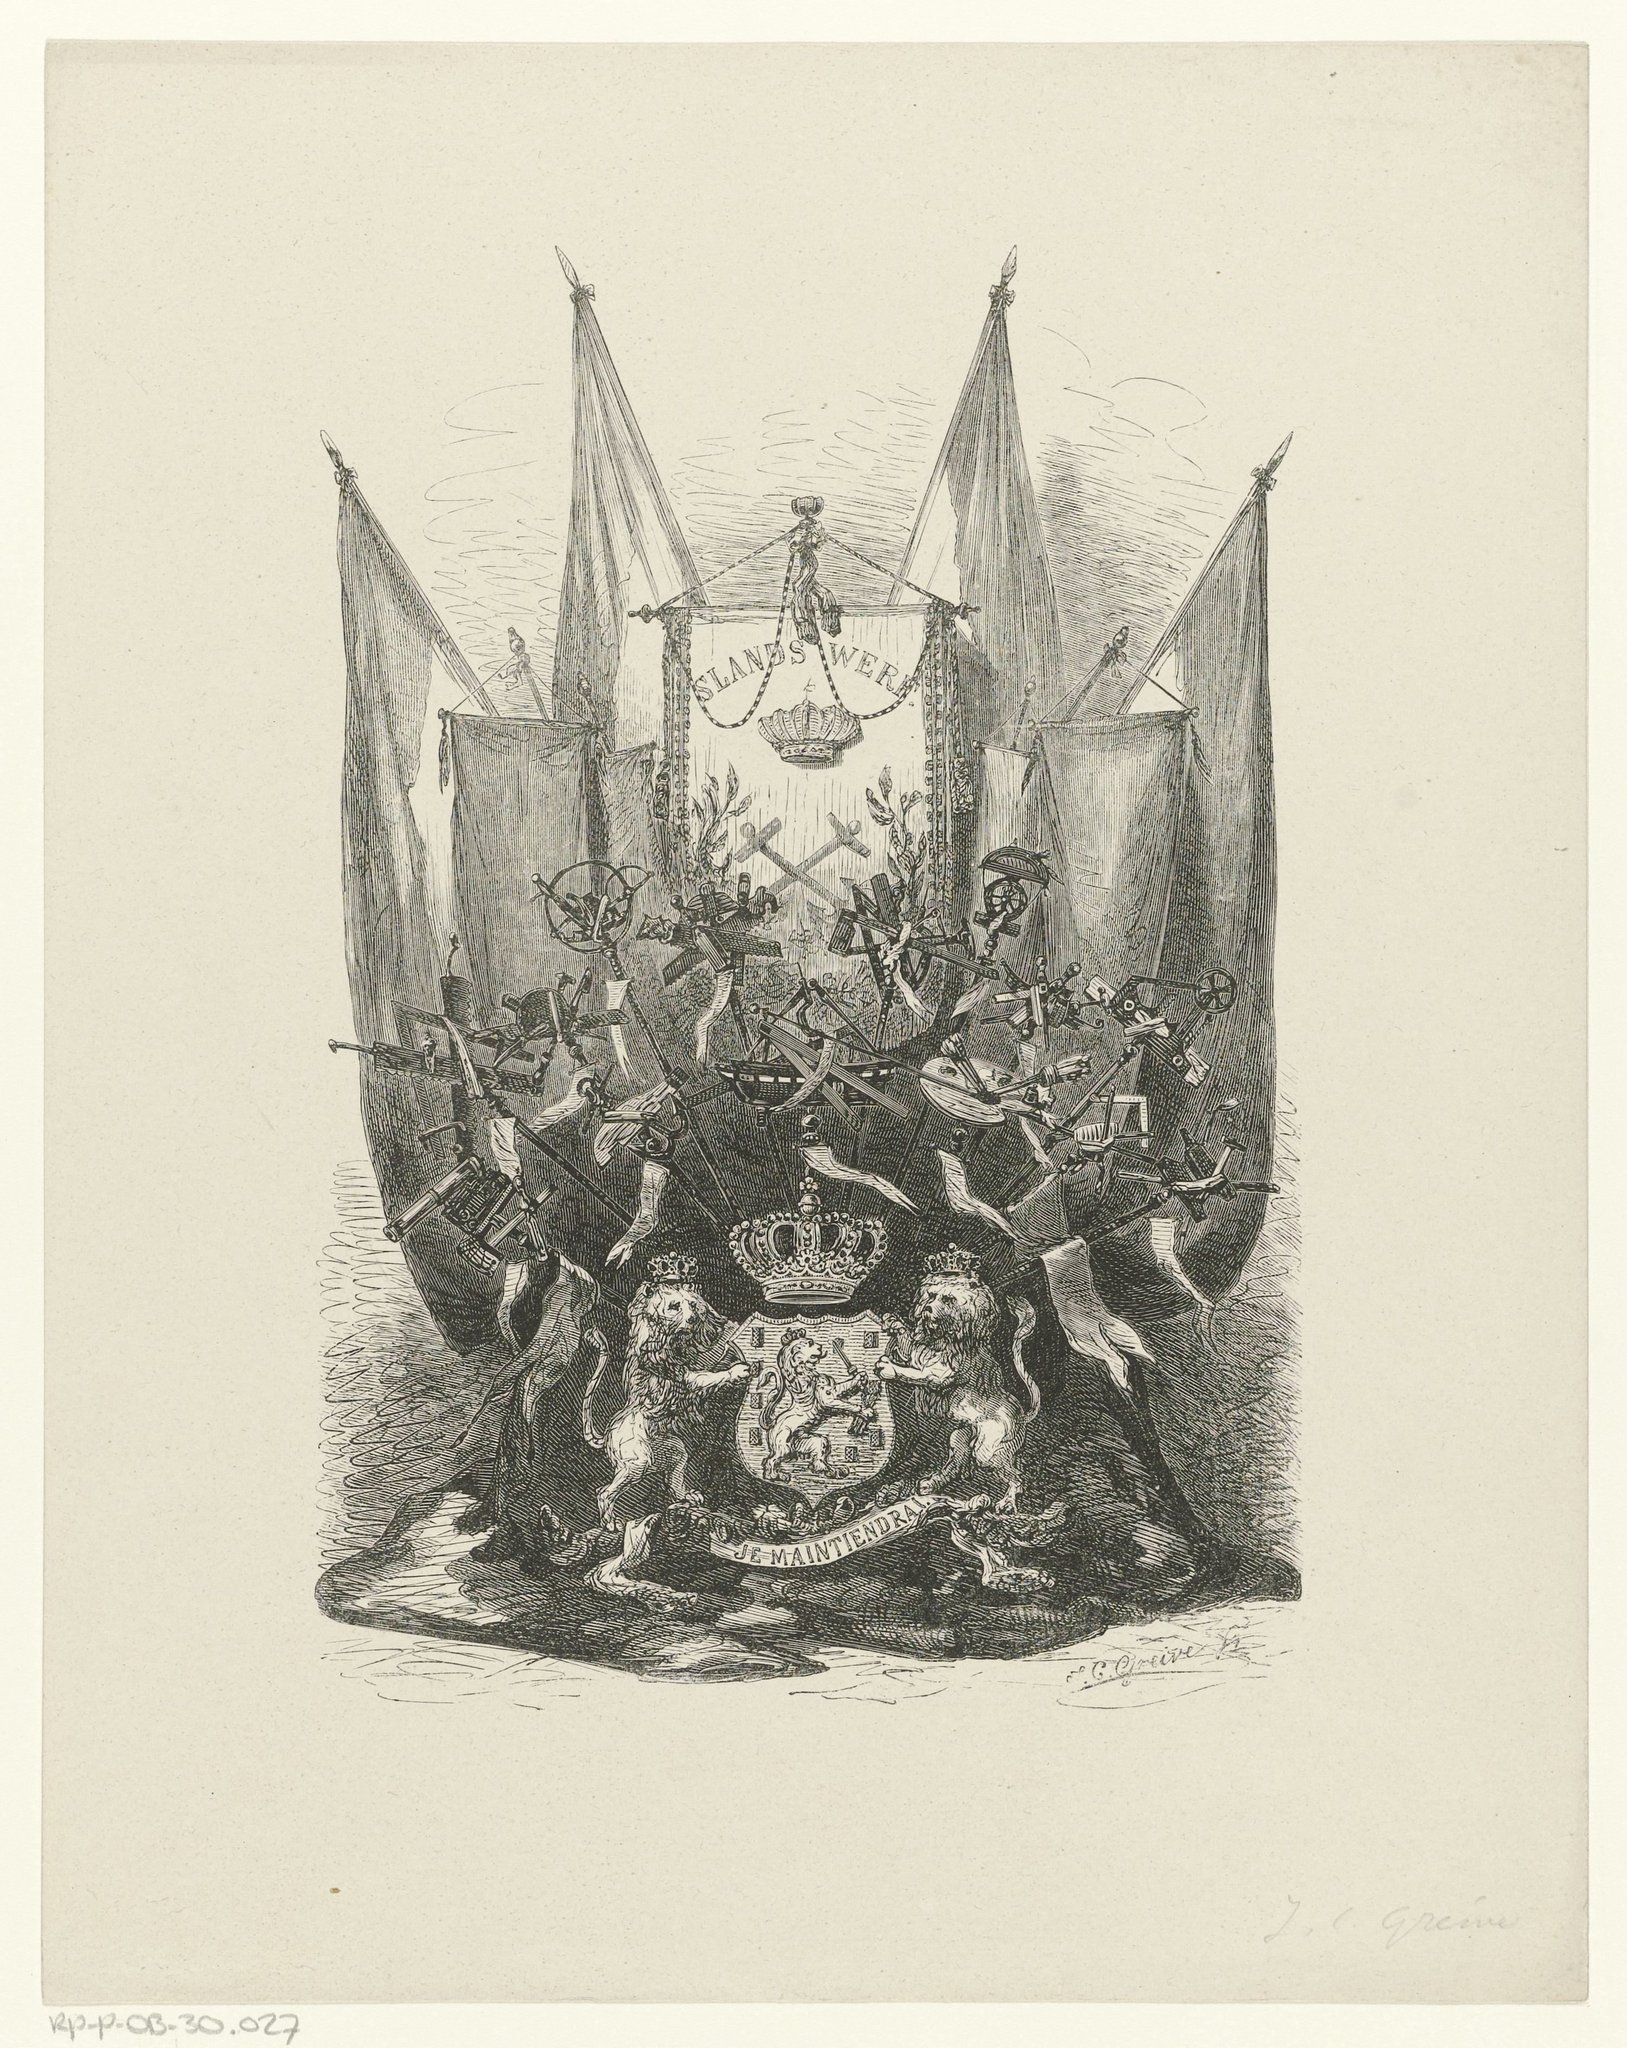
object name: print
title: Nederlandse scheepswerf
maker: johan conrad greive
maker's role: draughtsman, painter, print maker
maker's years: 1837-1891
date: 1847-1891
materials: paper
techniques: engraving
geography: amsterdam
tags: tools, aids, implements ~ crafts and industries, coat of arms (as symbol of the state, etc.) (+ nation; national), measuring-instruments, colours, pigments, and paints, shipbuilding industry, ship-model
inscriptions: collector's mark: Lugt 2228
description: Het wapen van Nederland met zijn devies, een kroon en twee leeuwen. Daar omheen meerdere objecten uit de scheepsbouw, waaronder meetinstrumenten, gereedschap, verf en scheepsmodellen.